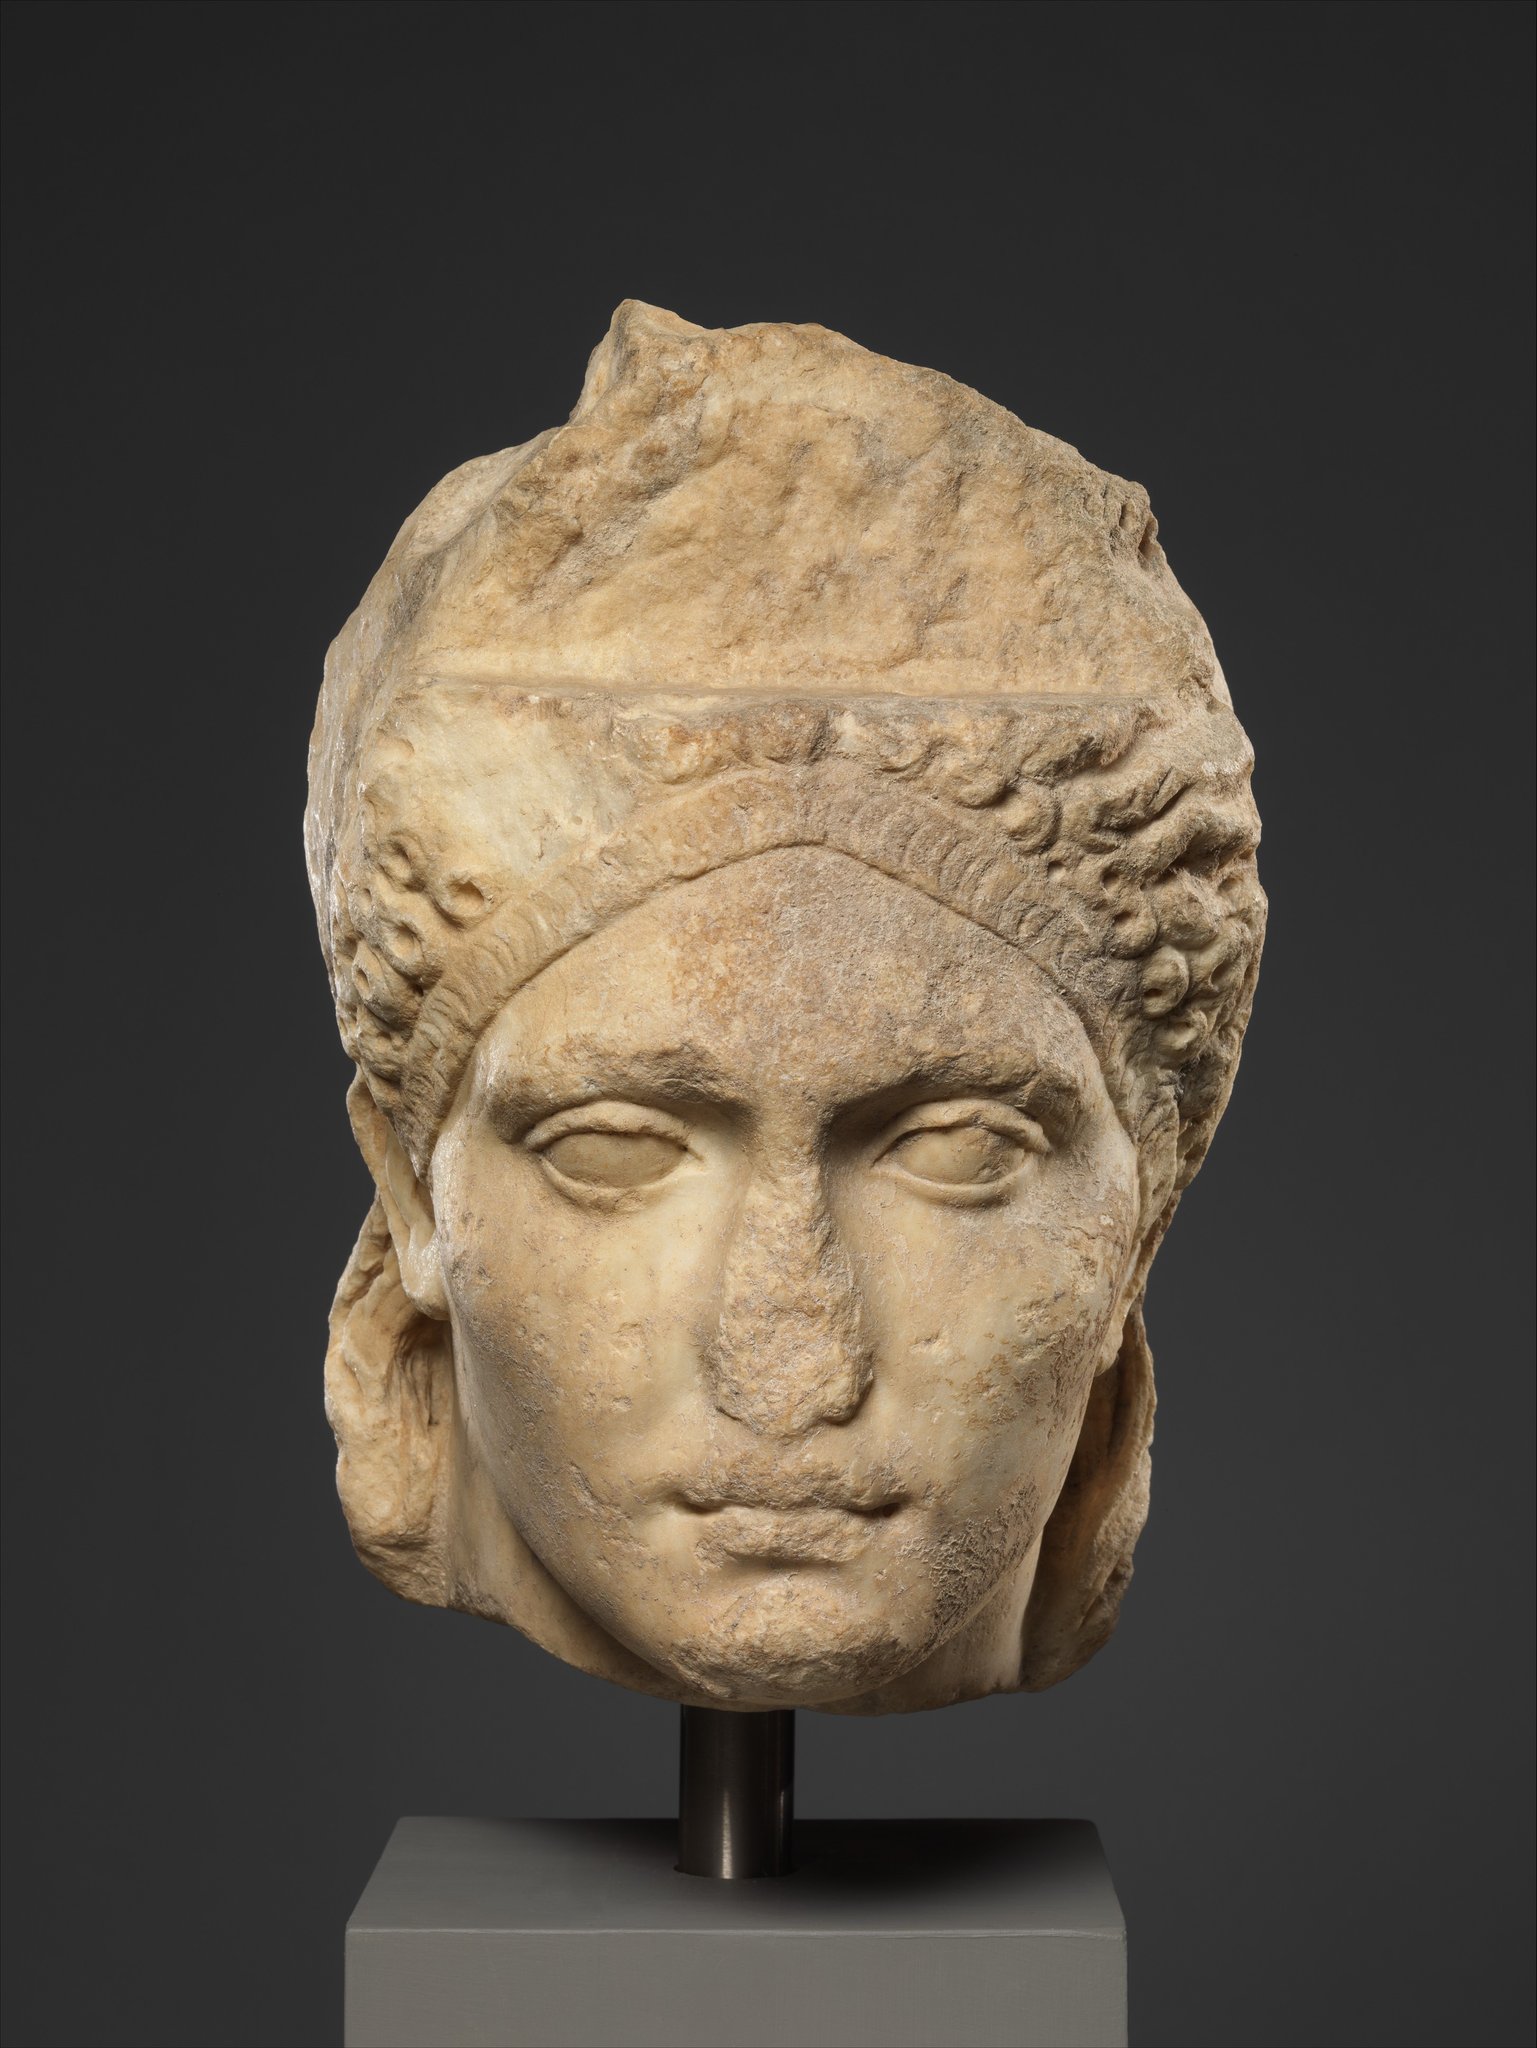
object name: portrait bust of a woman, the empress sabina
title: Over-life-sized marble portrait, probably of the empress Sabina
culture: roman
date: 121-128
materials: marble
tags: heads,women